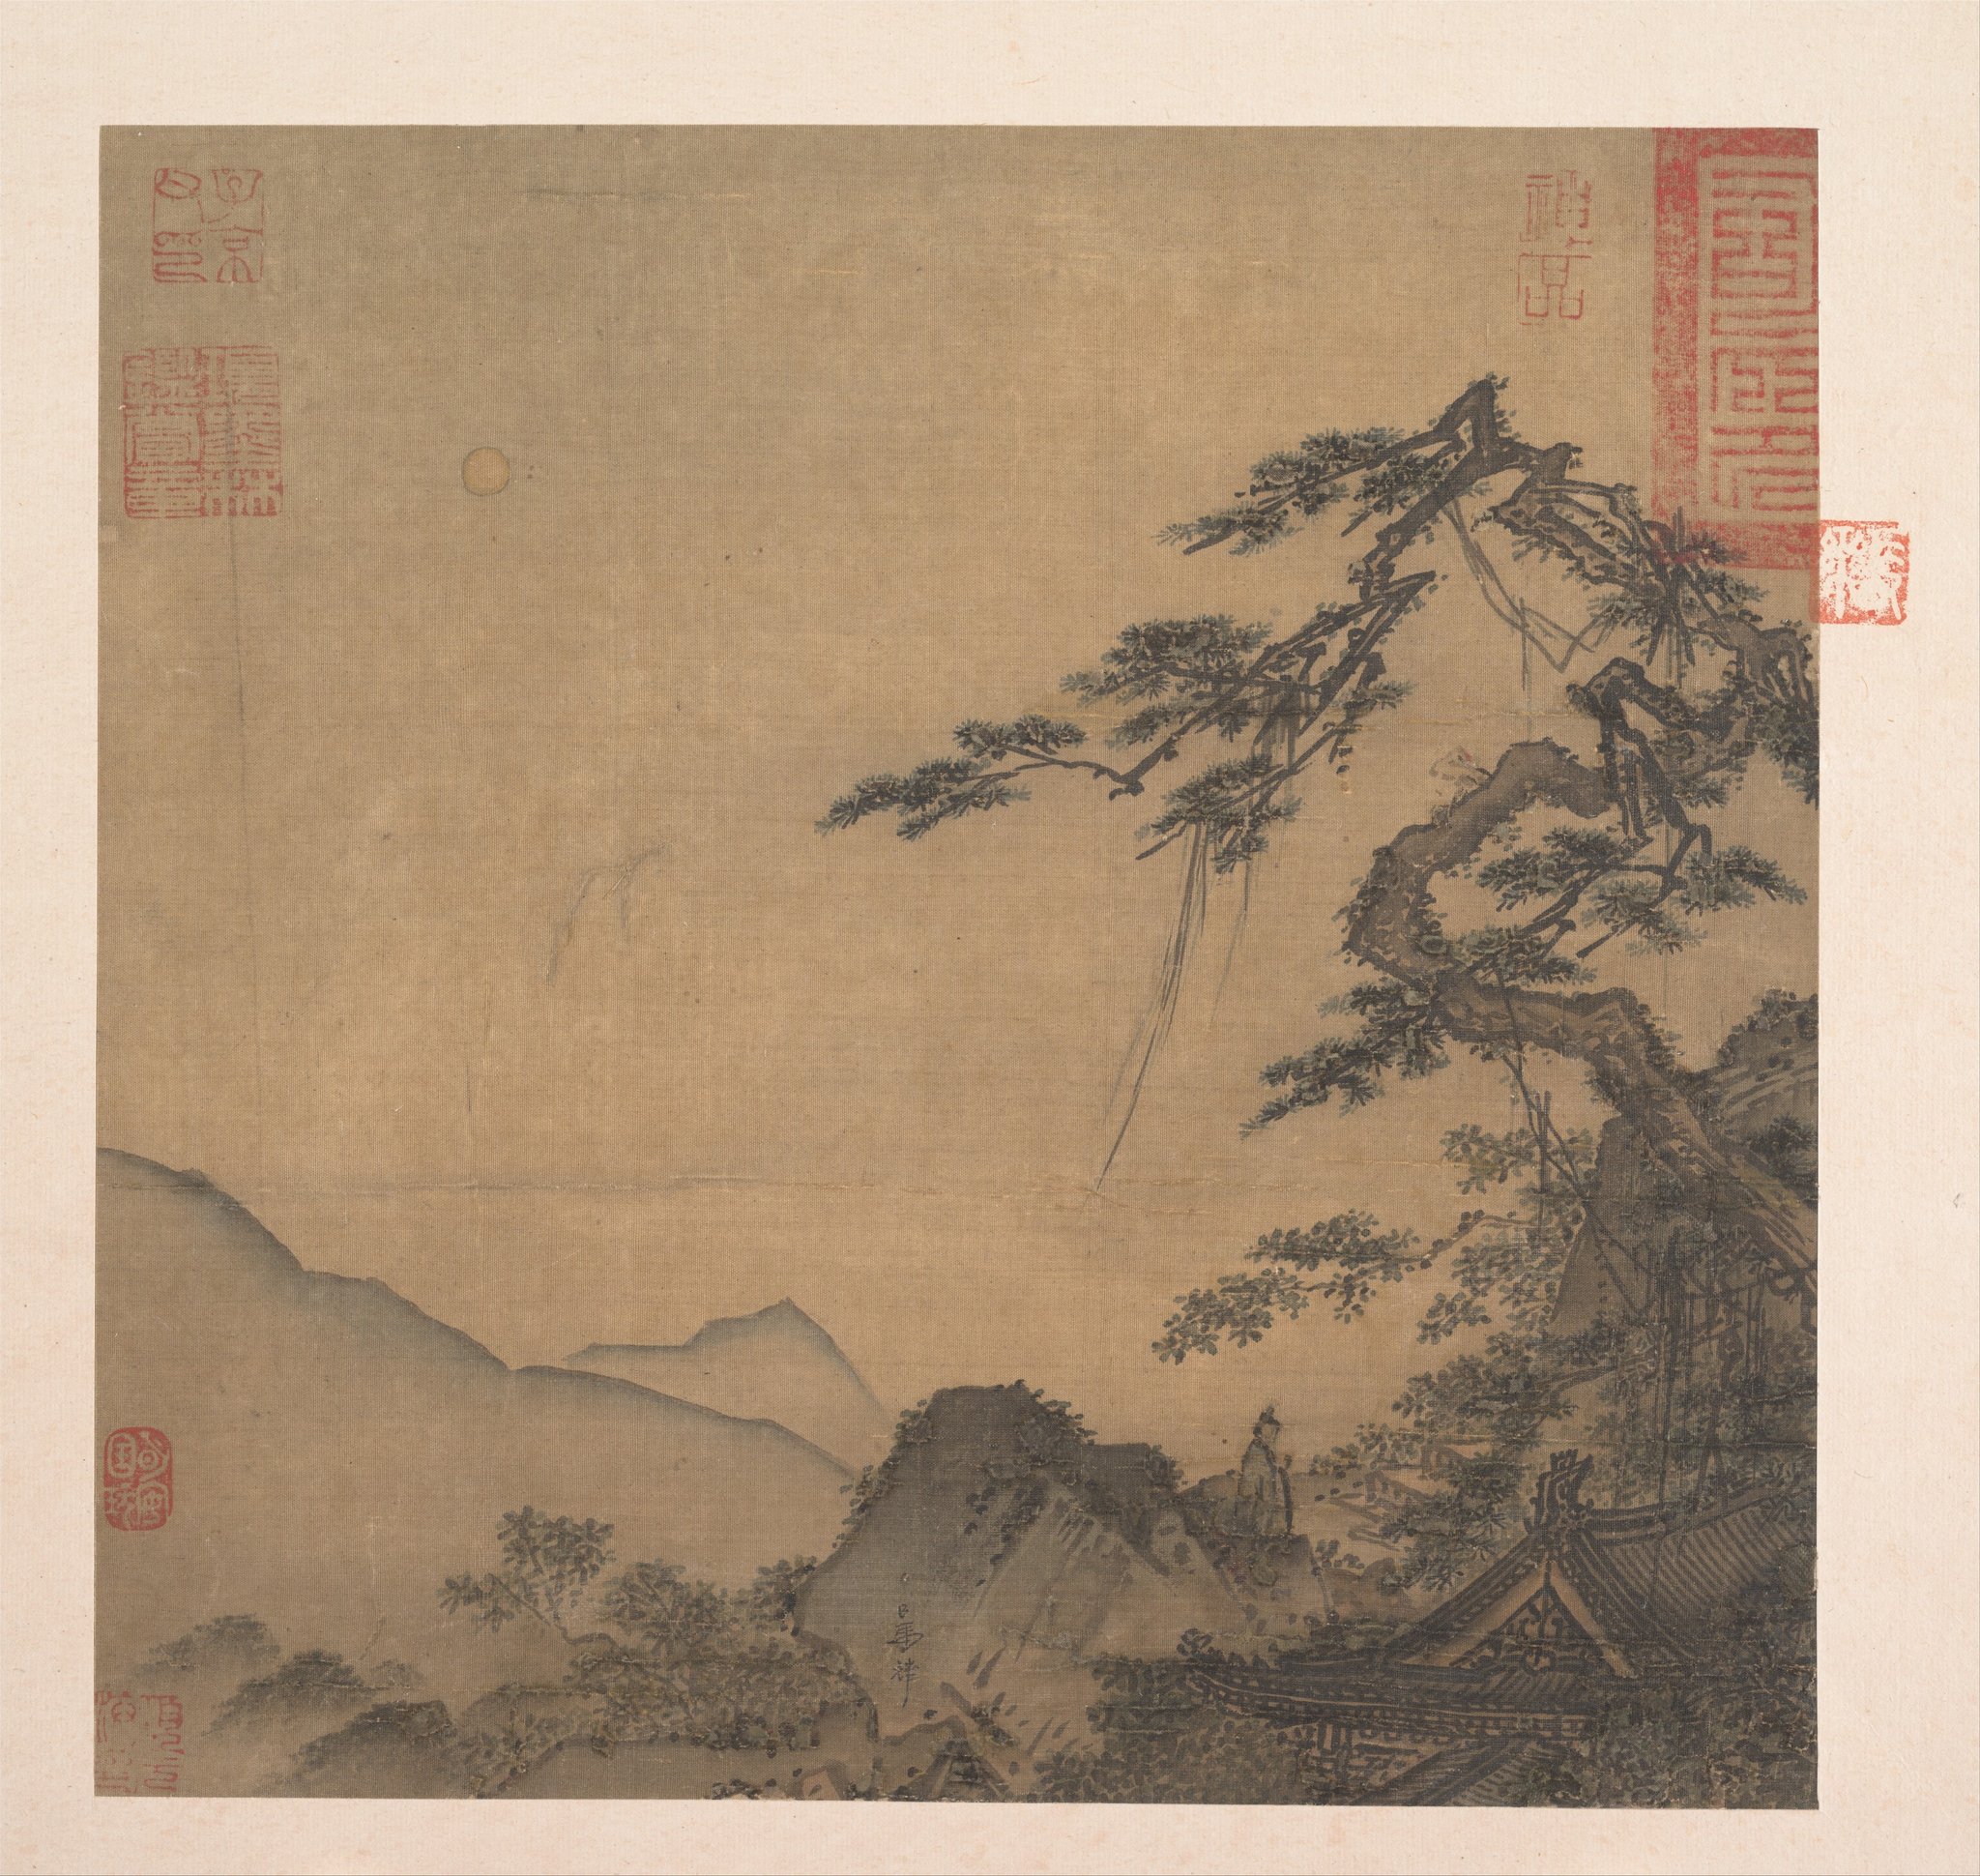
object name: album leaf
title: Landscape with great pine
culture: chinese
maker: ma lin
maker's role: artist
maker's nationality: chinese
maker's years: 1180-1256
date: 1226-1250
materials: ink, silk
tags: landscapes,trees